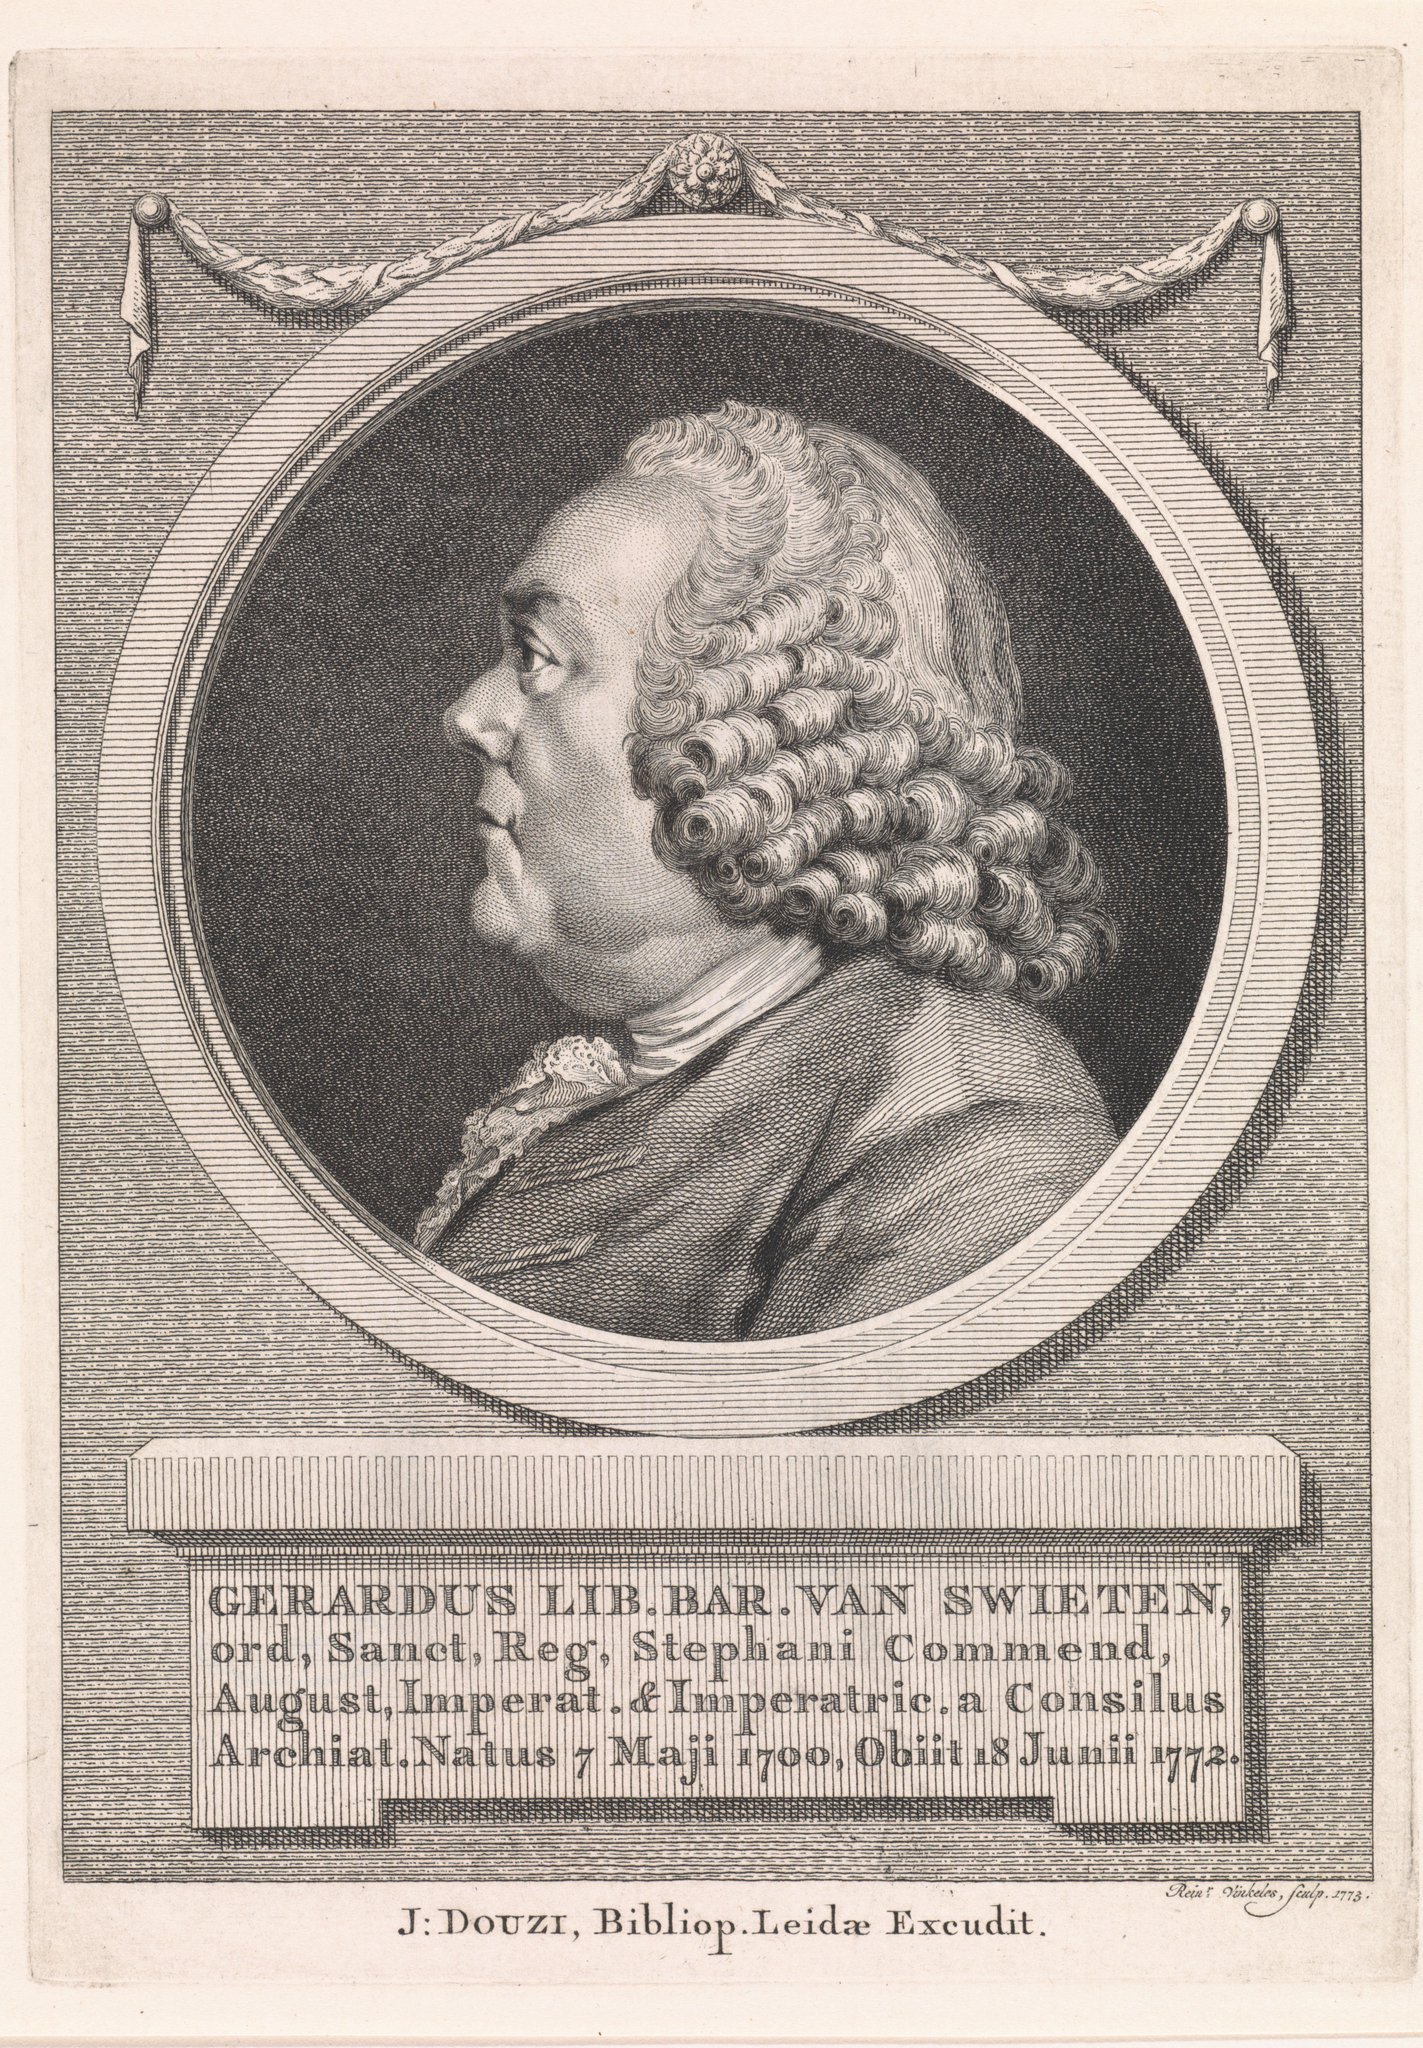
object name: print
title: Portret van Gerard baron van Swieten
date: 1773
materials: paper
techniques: engraving, etching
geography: leiden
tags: vienna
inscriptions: collector's mark: Lugt 2228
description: Portret van Gerard baron van Swieten, medicus en hoogleraar te Leiden en Wenen.